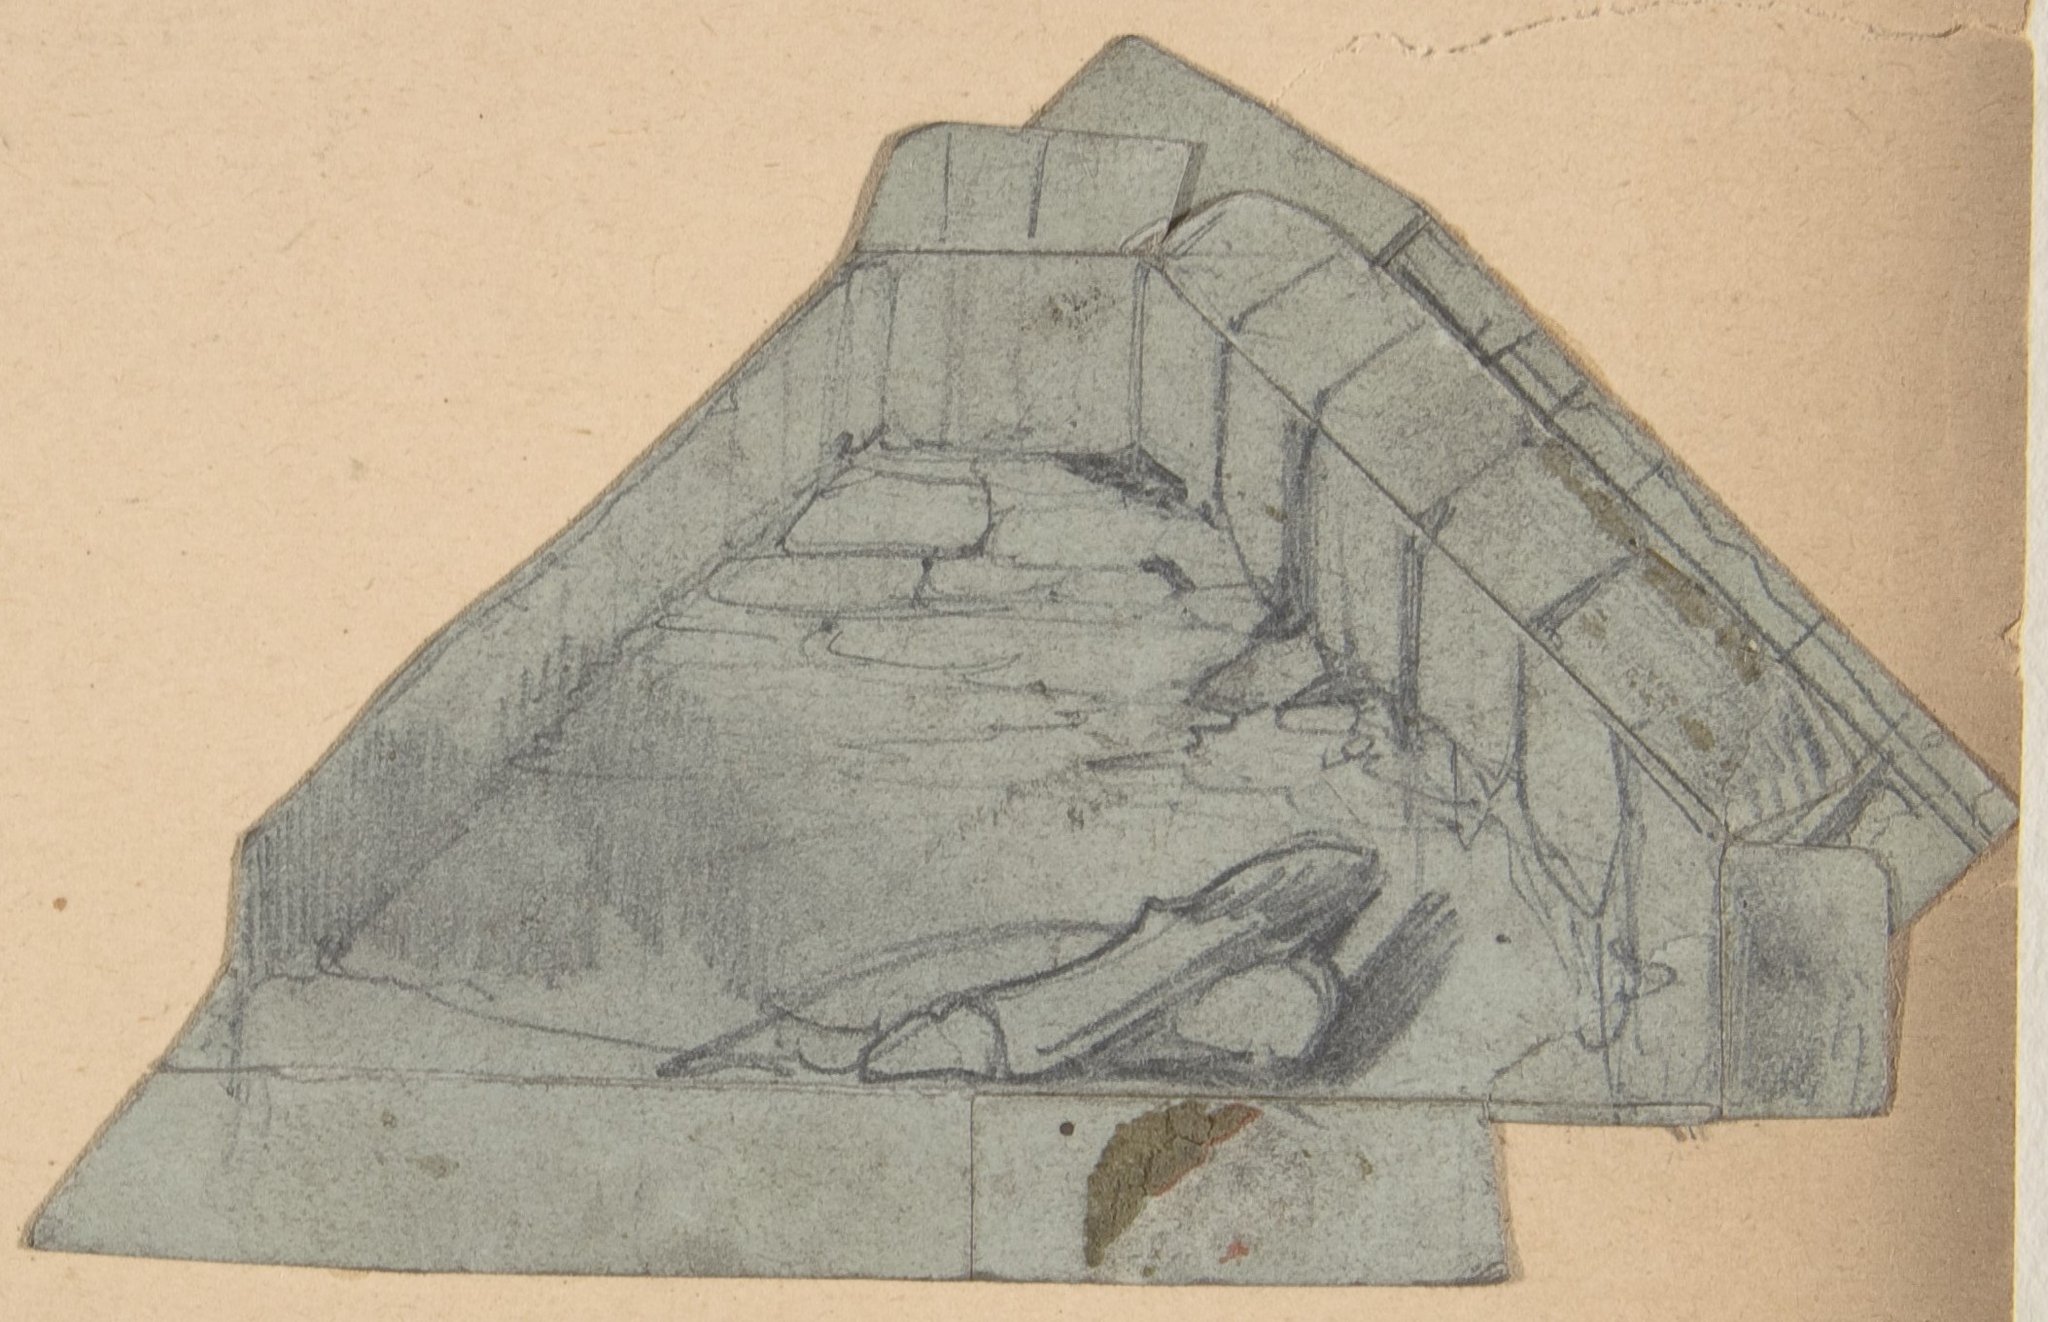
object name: drawing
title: Design for a Stage Set at the Opéra, Paris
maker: eugène cicéri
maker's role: artist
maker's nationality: french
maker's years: 1813-1890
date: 1830-1890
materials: graphite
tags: stage design